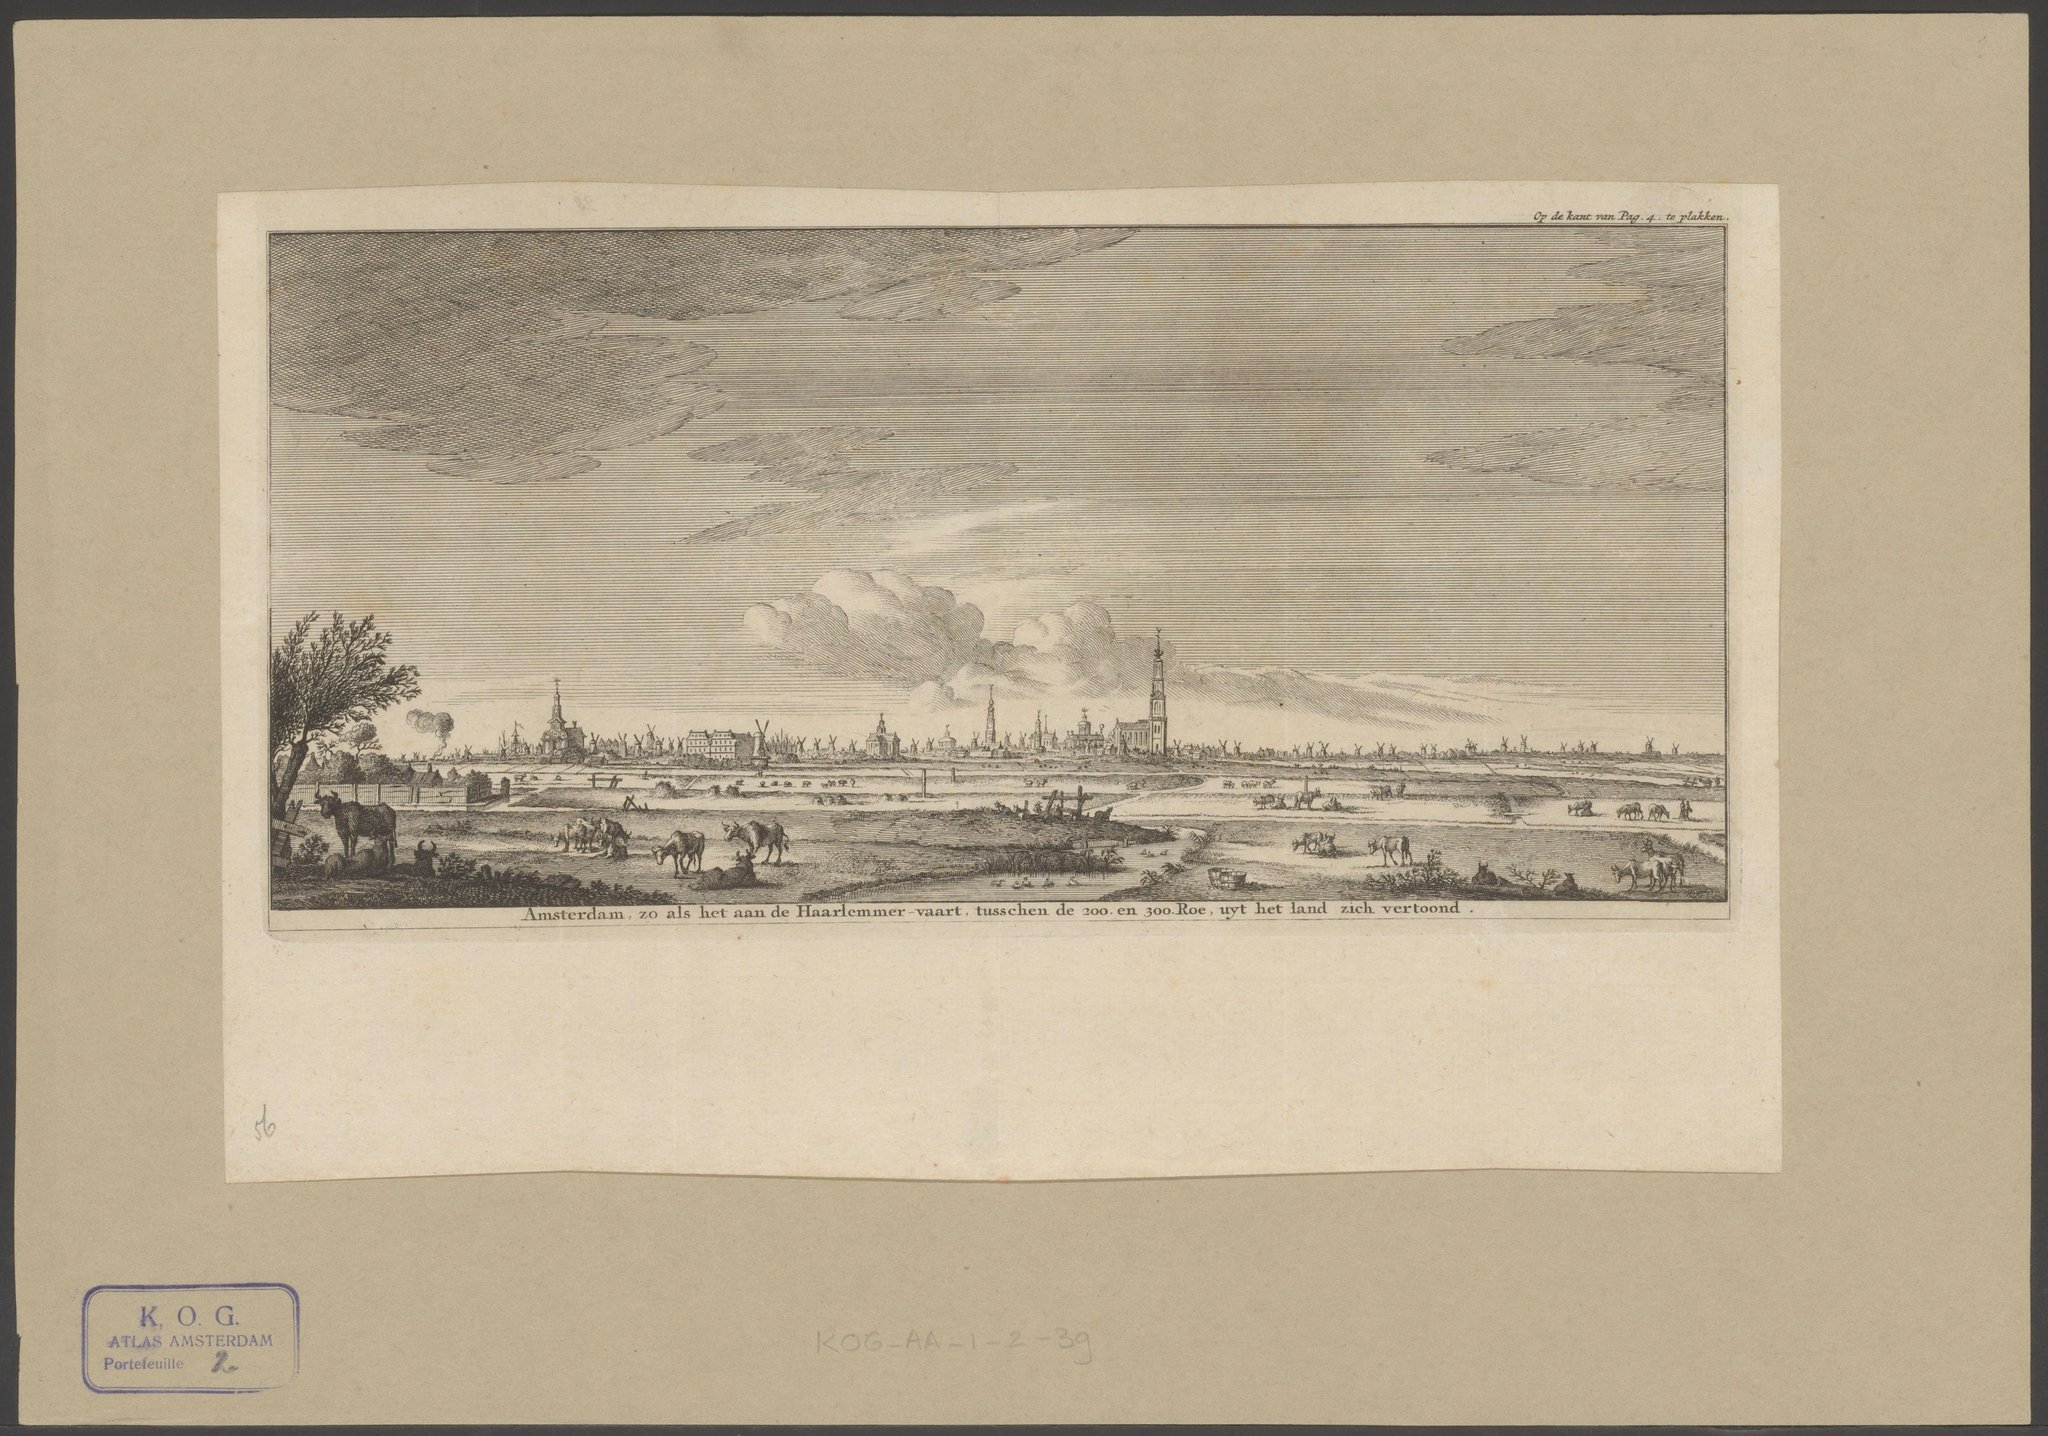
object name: print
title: Amsterdam, zo als het aan de Haarlemmer-vaart, tusschen de 200. en 300. Roe, uyt het land zich vertoond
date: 1723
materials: paper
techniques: etching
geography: amsterdam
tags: city-view in general; 'veduta', cattle, windmill in landscape, parts of church exterior and annexes: spire, amsterdam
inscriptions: collector's mark: ‘2-’ Lugt 1641b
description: Prent waarschijnlijk uit: Willink, Daniël. Amsterdamsche Buitensingel nevens de omleggende dorpen, opgeheldert door aanteekeningen over veele voornaame geschiedeniszen: met afbeeldingen (…) Amsterdam: Andries van Damme, 1723, p. 4.